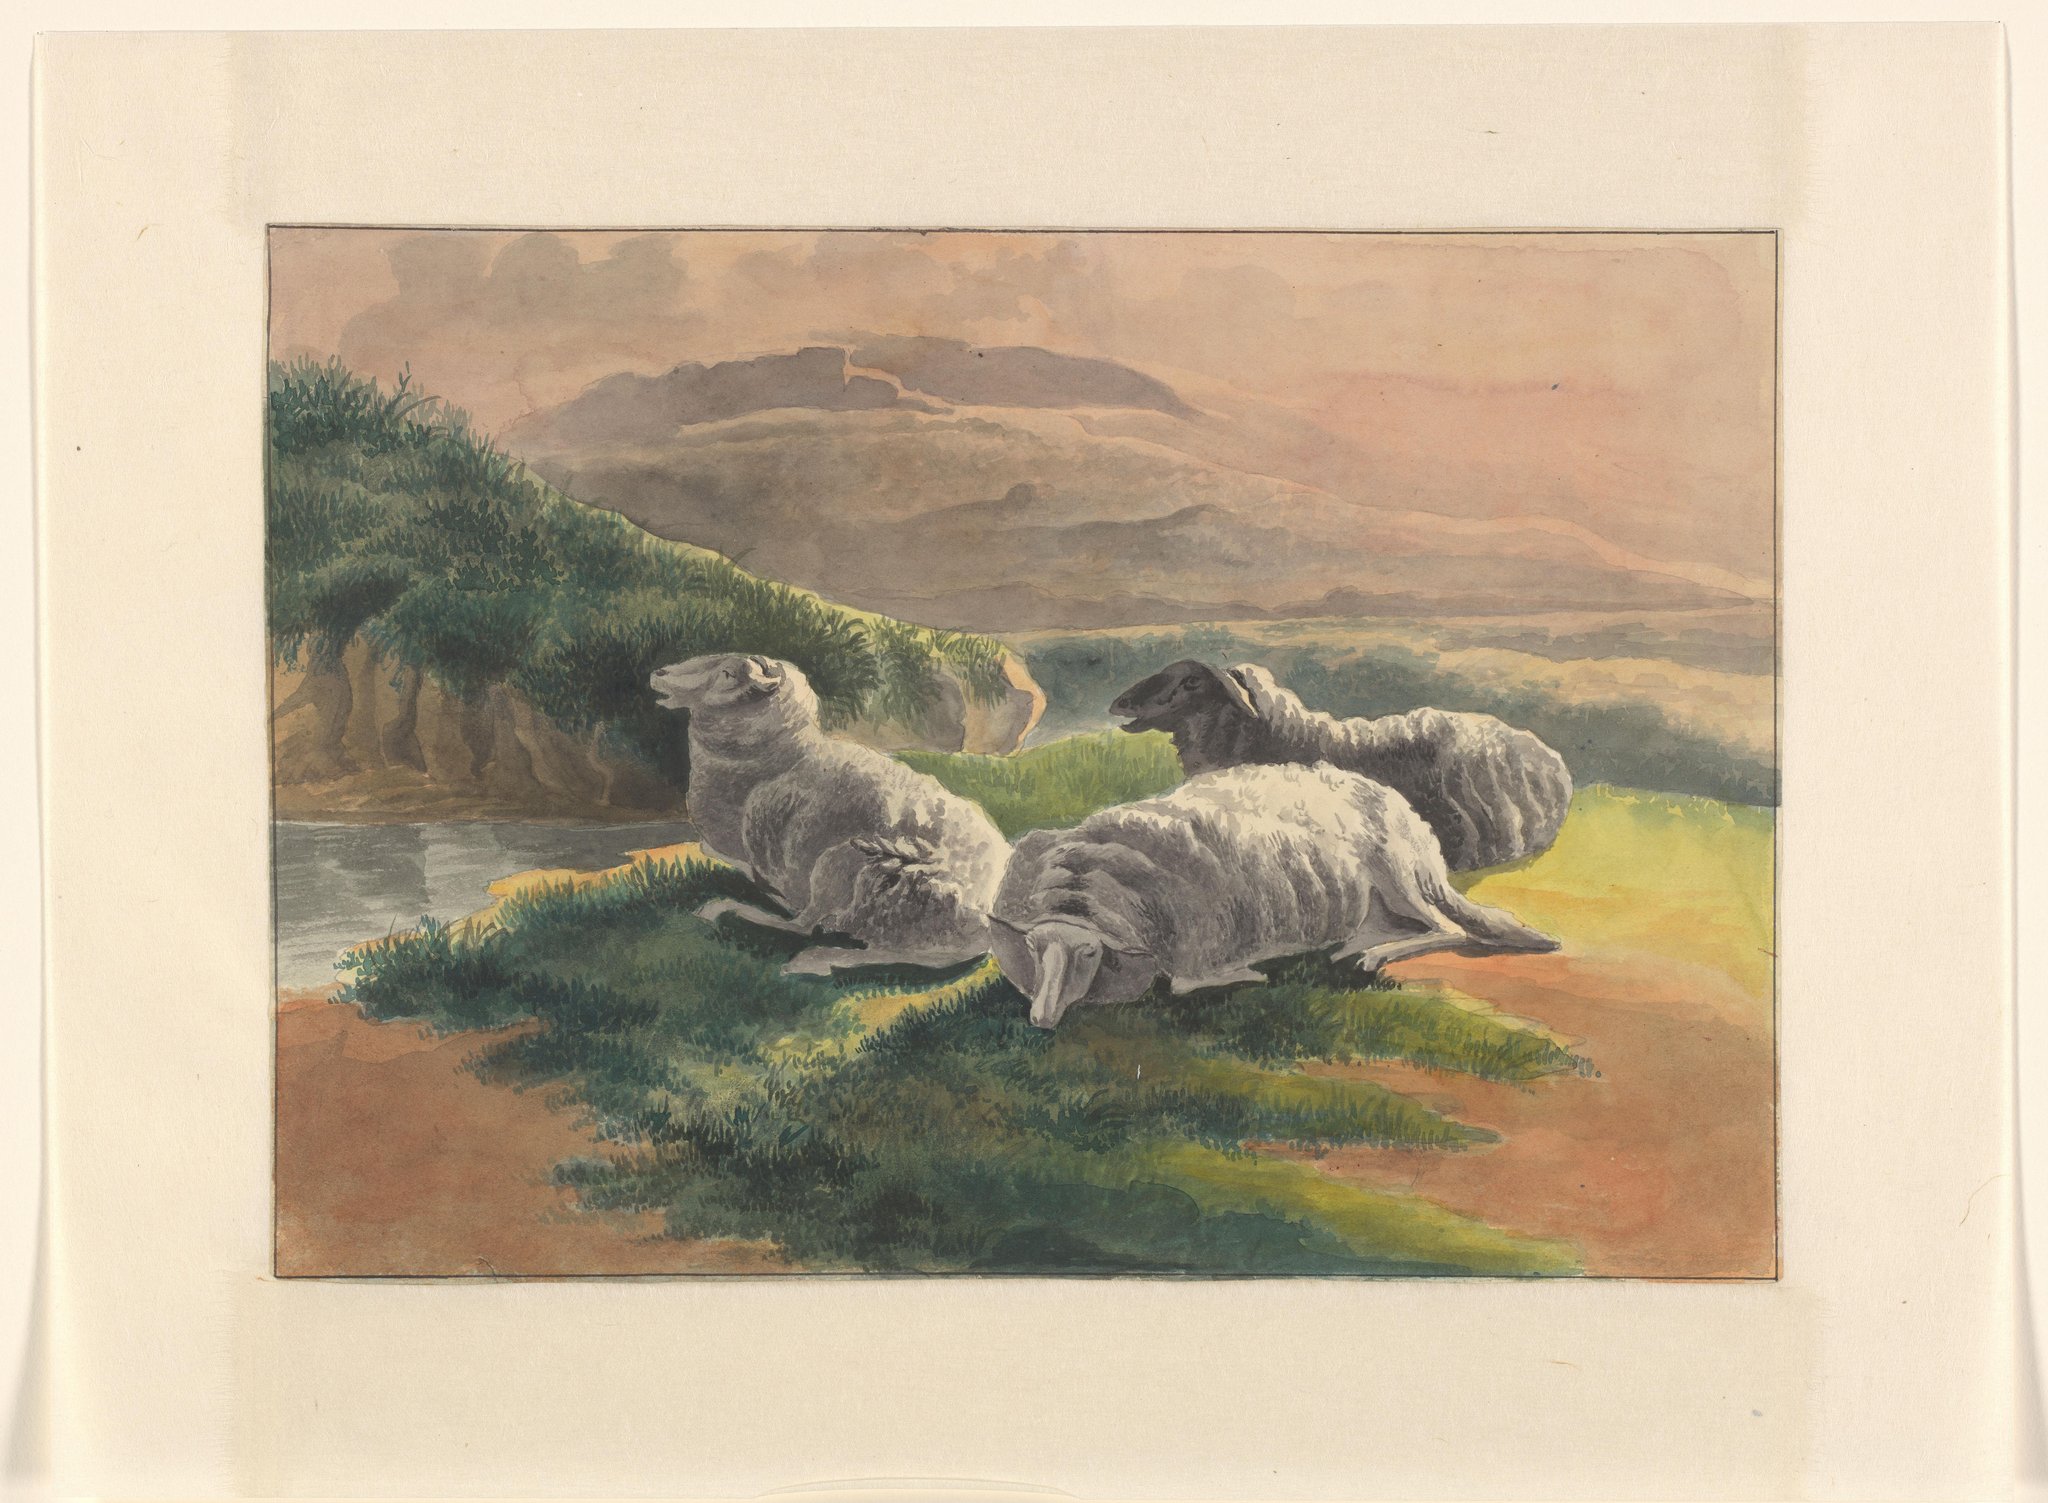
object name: drawing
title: Drie schapen in een landschap bij zonsondergang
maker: johannes van reijn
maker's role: draughtsman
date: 1800-1900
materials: paper, pencil, watercolor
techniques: brush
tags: landscapes, sheep